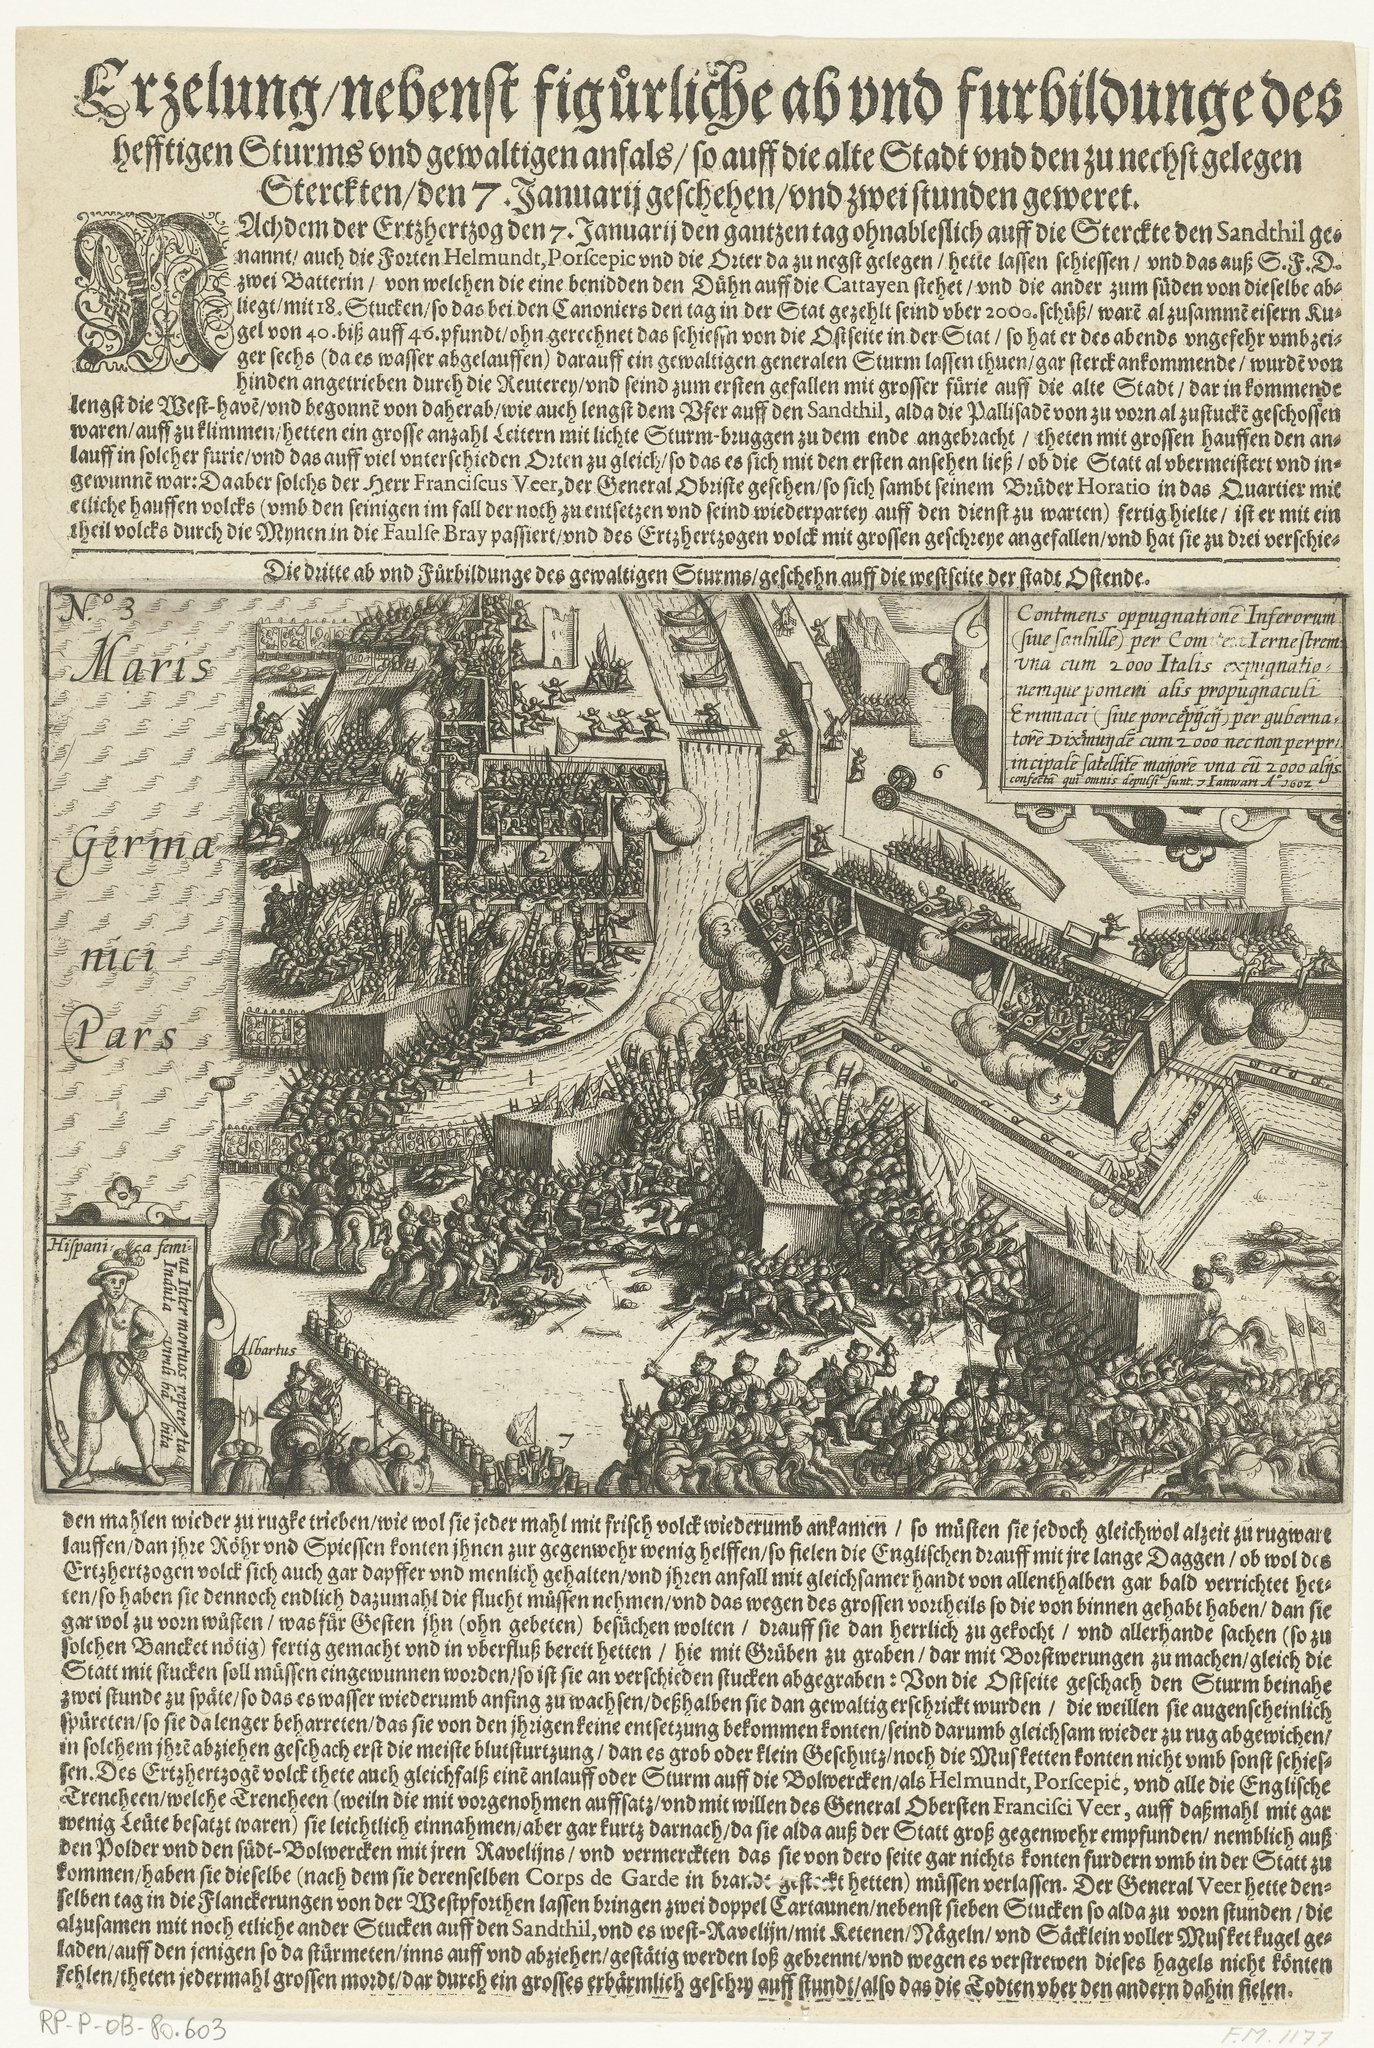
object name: print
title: Erzelung / nebenst figurlichr ab und furbildunge des hefftigen Sturms und gewaltigen anfals / so auff die alte Stadt und den zu nechst gelegen Sterckten / den 7. Januarij geschehen / und zwei stunden geweret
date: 1602-1604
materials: paper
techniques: etching, letterpress printing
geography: low countries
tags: brussels, albrecht aartshertog van oostenrijk, siege, position war, battle (+ land forces)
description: Uitgegeven als onderdeel van een grote nieuwsprent (zie Paas P-17), ook gebruikt in: J.S., Belaegerung von Ostende : Journal... von alle ghedenckwürdigste Sachen... so in der... Statt und auch aussen da fur... von den 5.Julij 1601. bisshero auff diese... Ostermesse 1604, 1604 en Henrick Lodewijcxsoon van Haestens, De bloedige ende strenge belegeringhe der stadt Oostende in Vlaenderen, H.L. van Haestens, Leiden 1613.